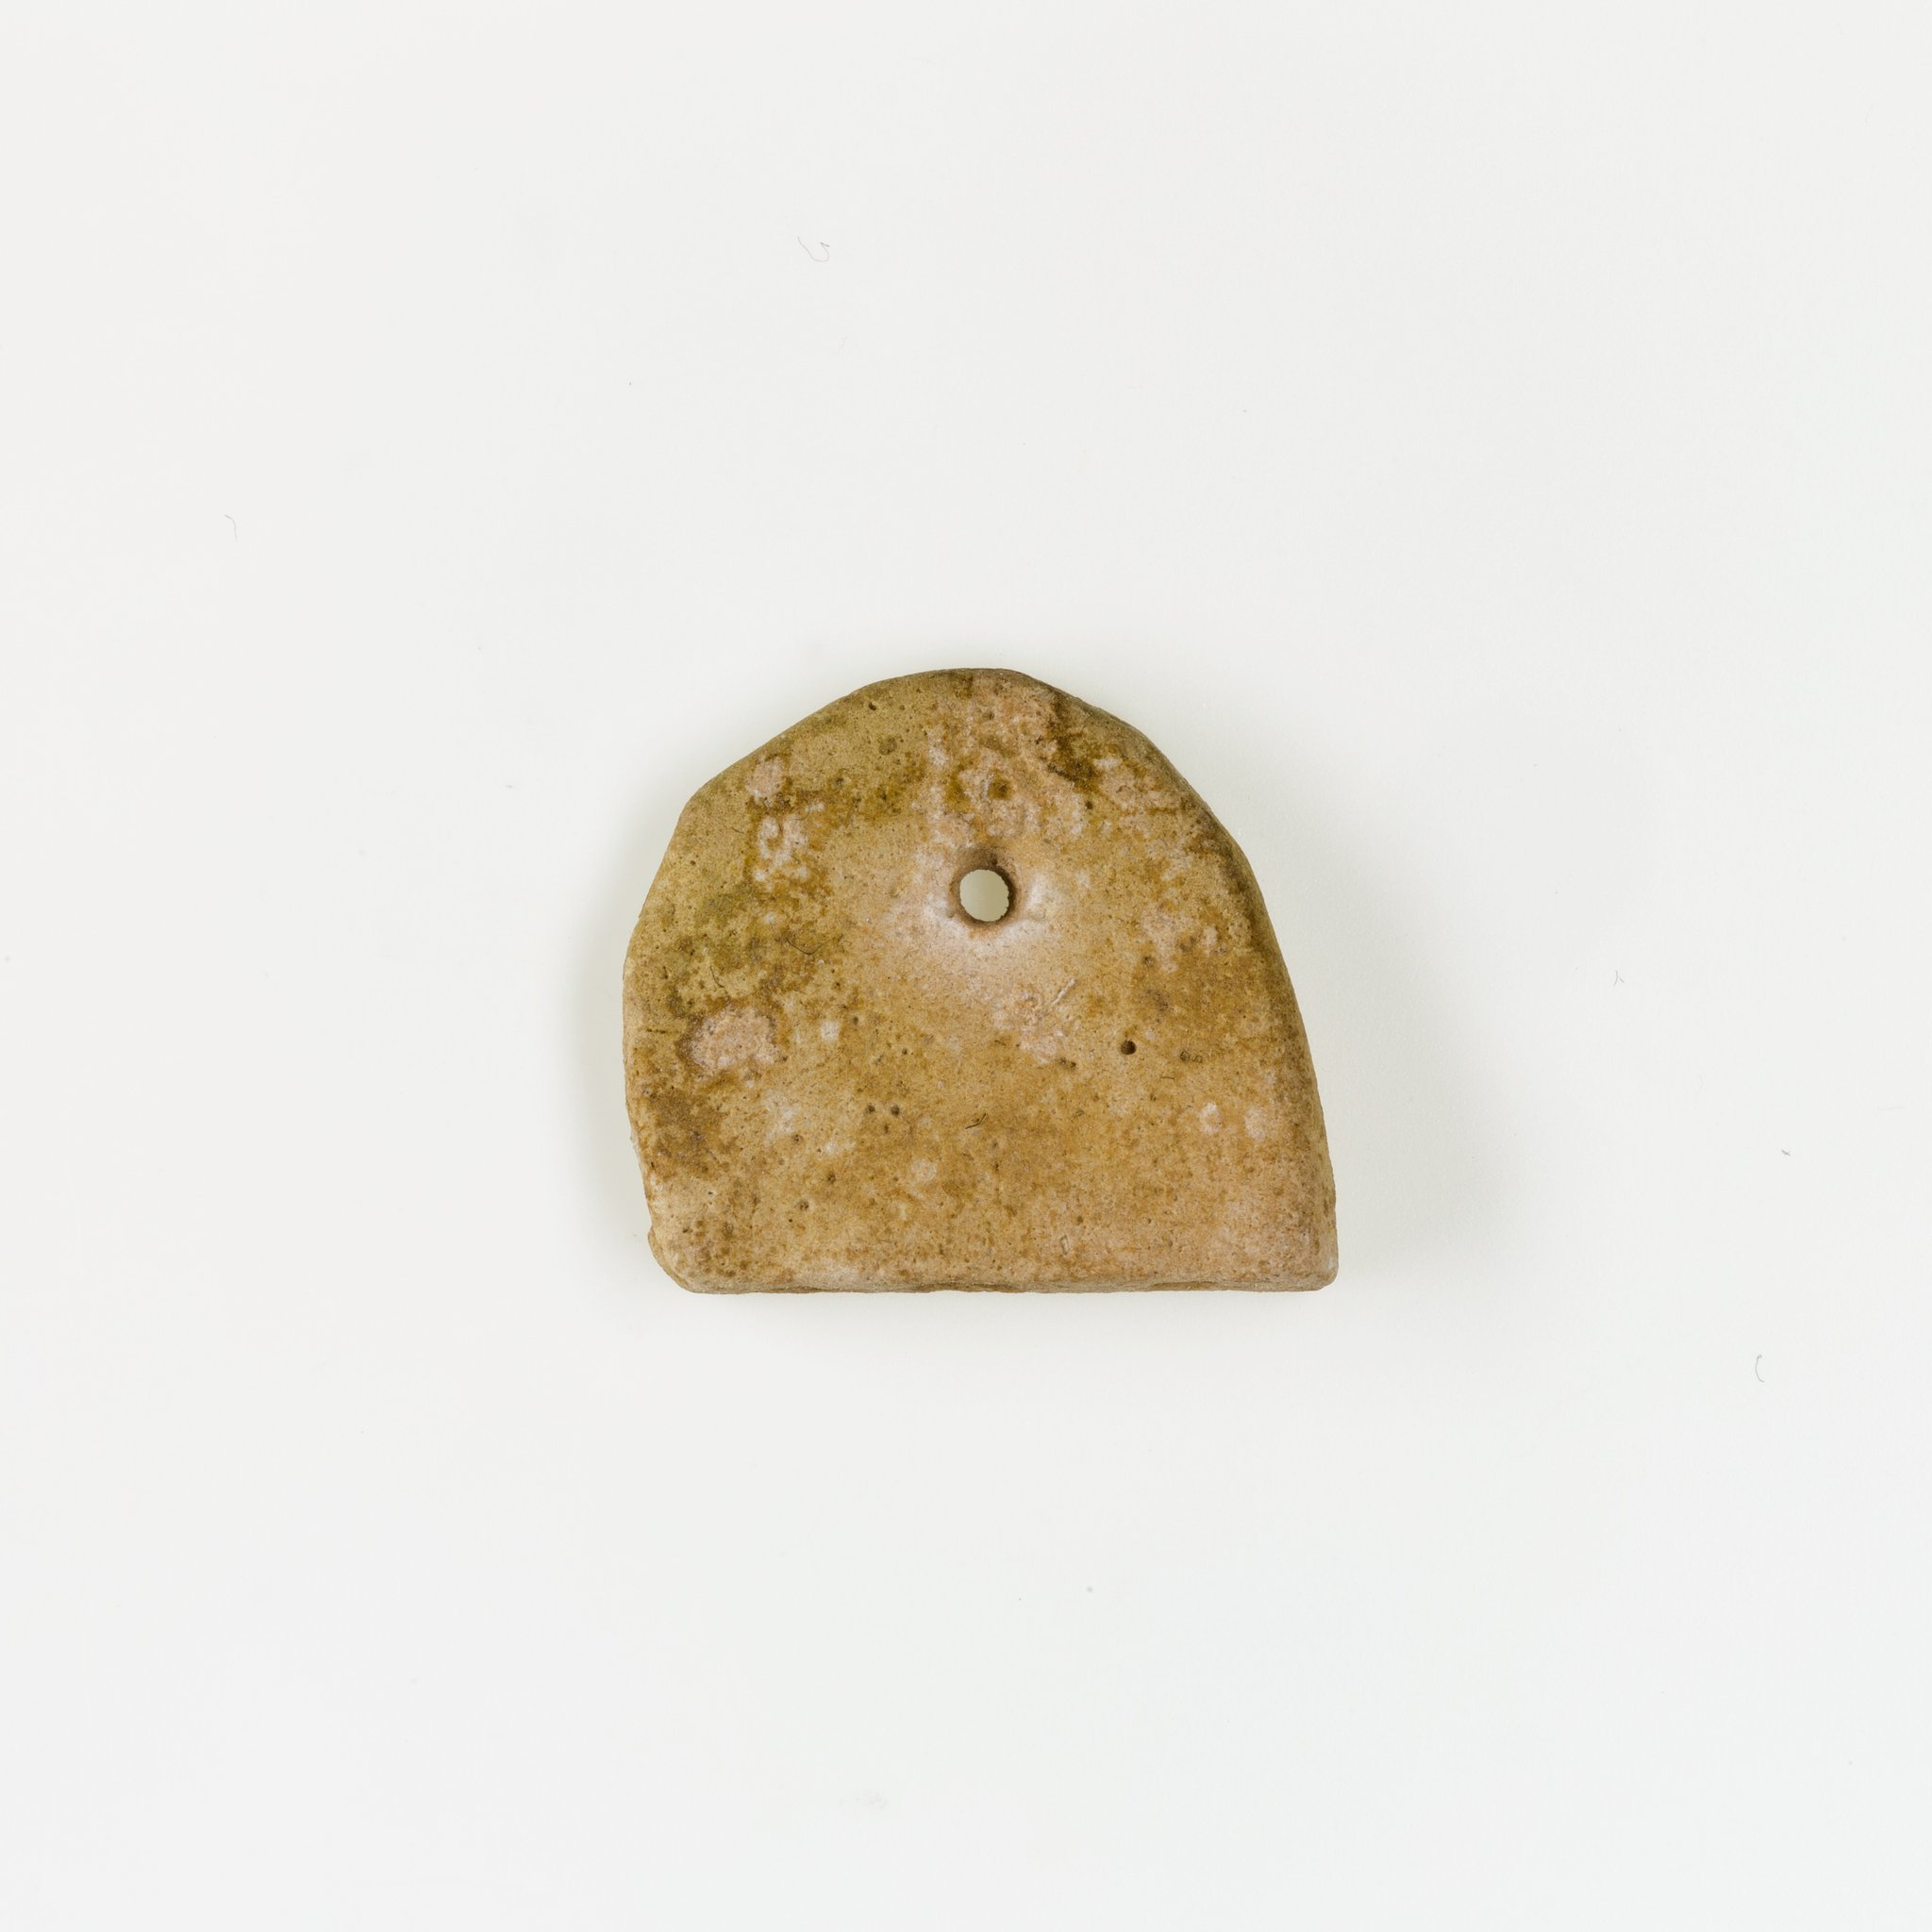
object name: broad collar piece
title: Broad Collar piece (?)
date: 1850-1640 BCE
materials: faience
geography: egypt